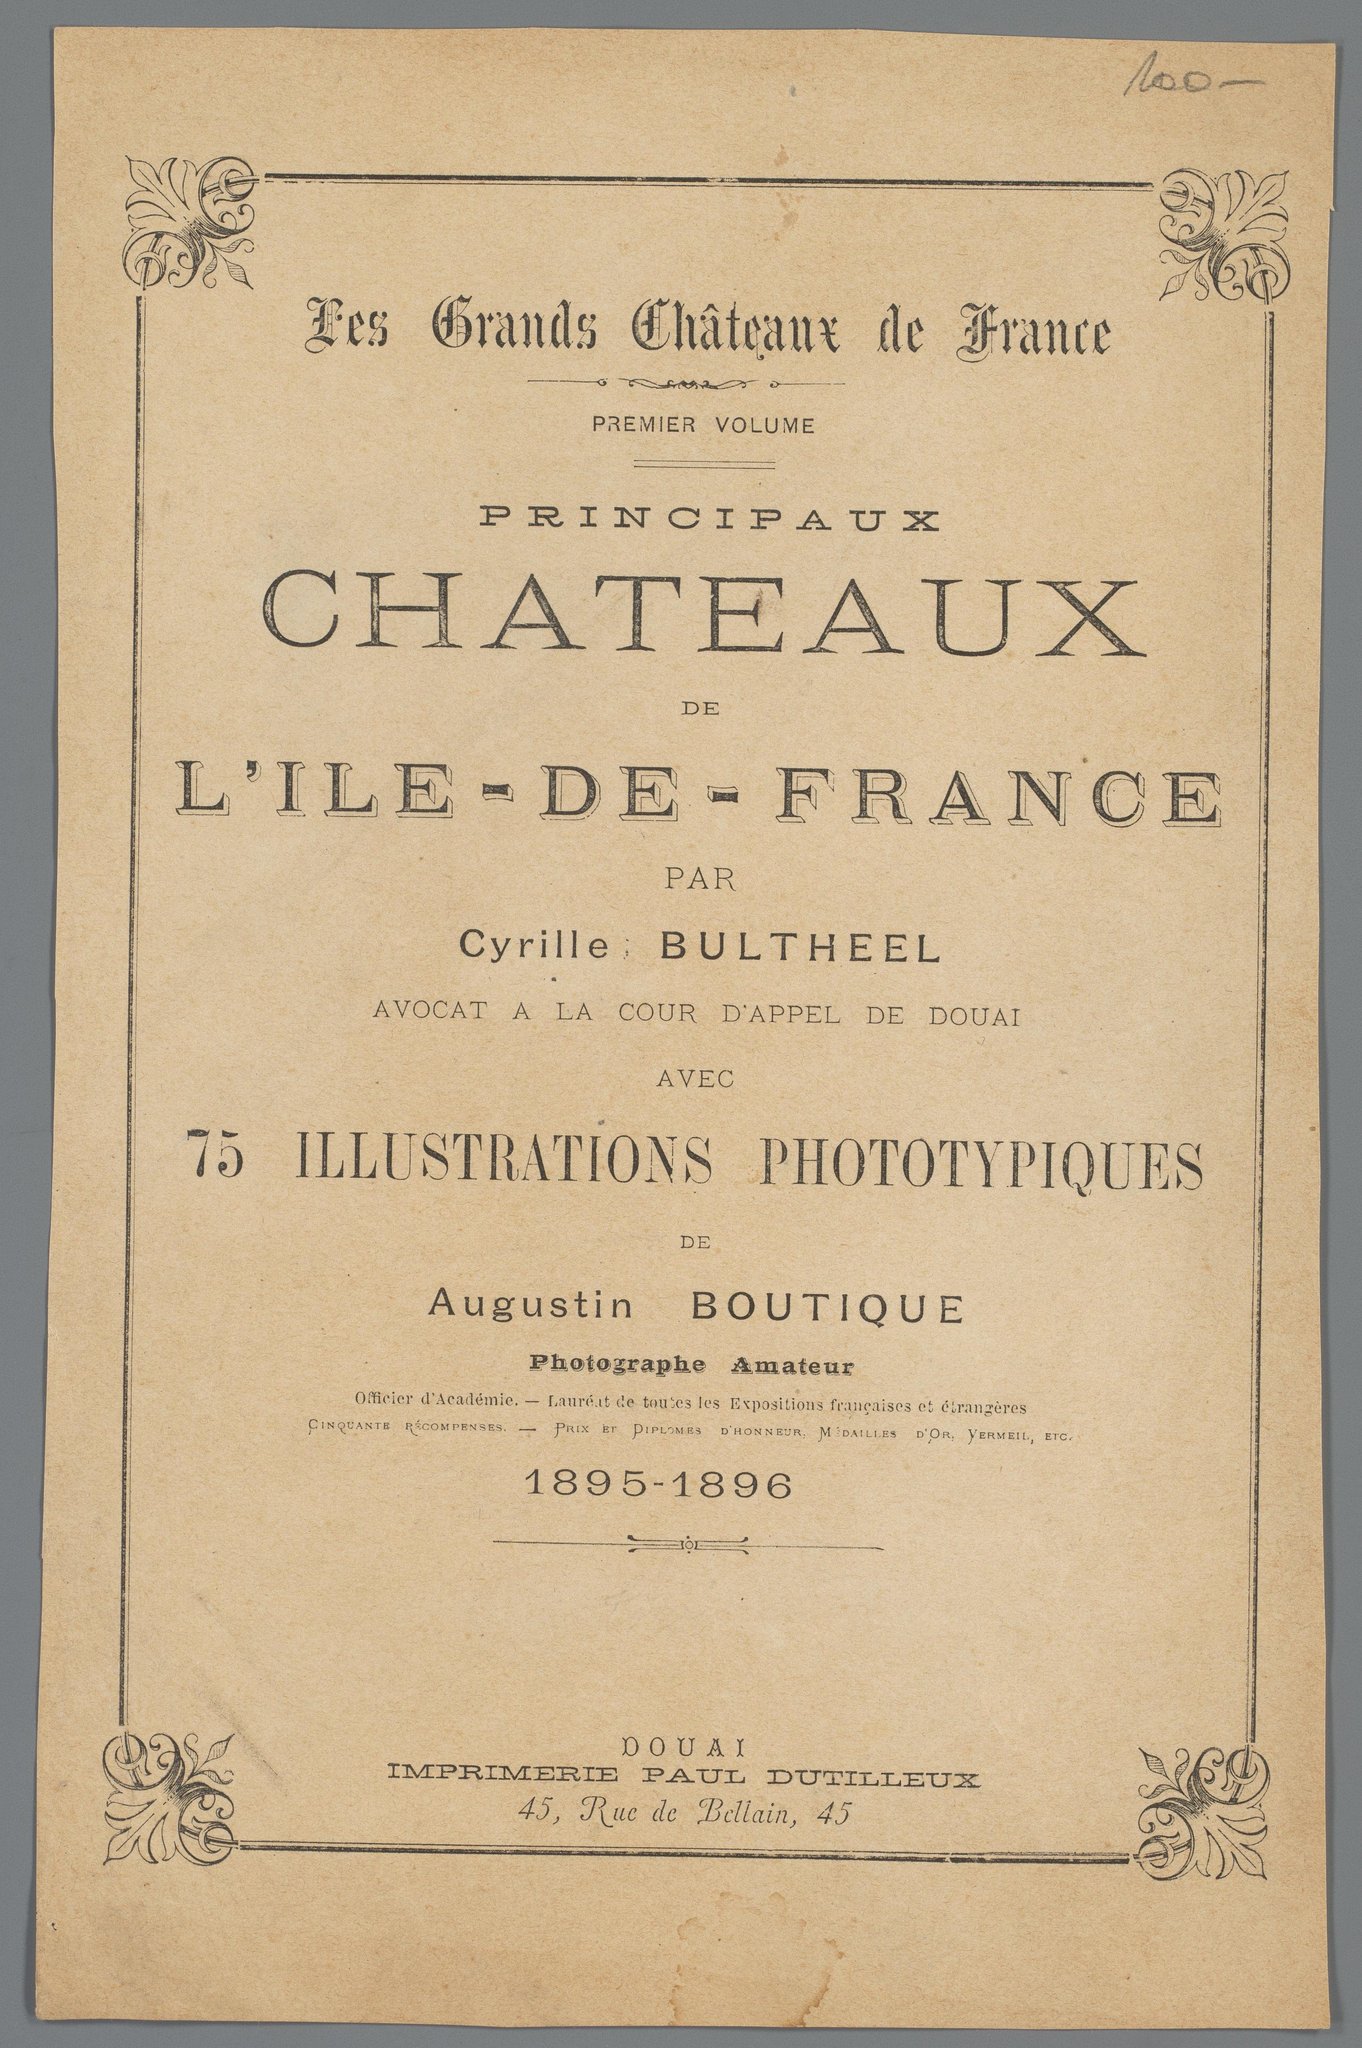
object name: titelblad, titelpagina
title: Titelpagina voor een fotomechanisch geïllustreerde uitgave over kastelen in Île-de-France, met tekst door Cyrille Bultheel en foto's door Augustin Boutique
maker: paul dutilleux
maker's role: printer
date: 1896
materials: paper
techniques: letterpress printing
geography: douai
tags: single printed leaf: broadsheet, leaflet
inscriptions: address: ‘DOUAI/ 45, Rue de Bellain, 45’